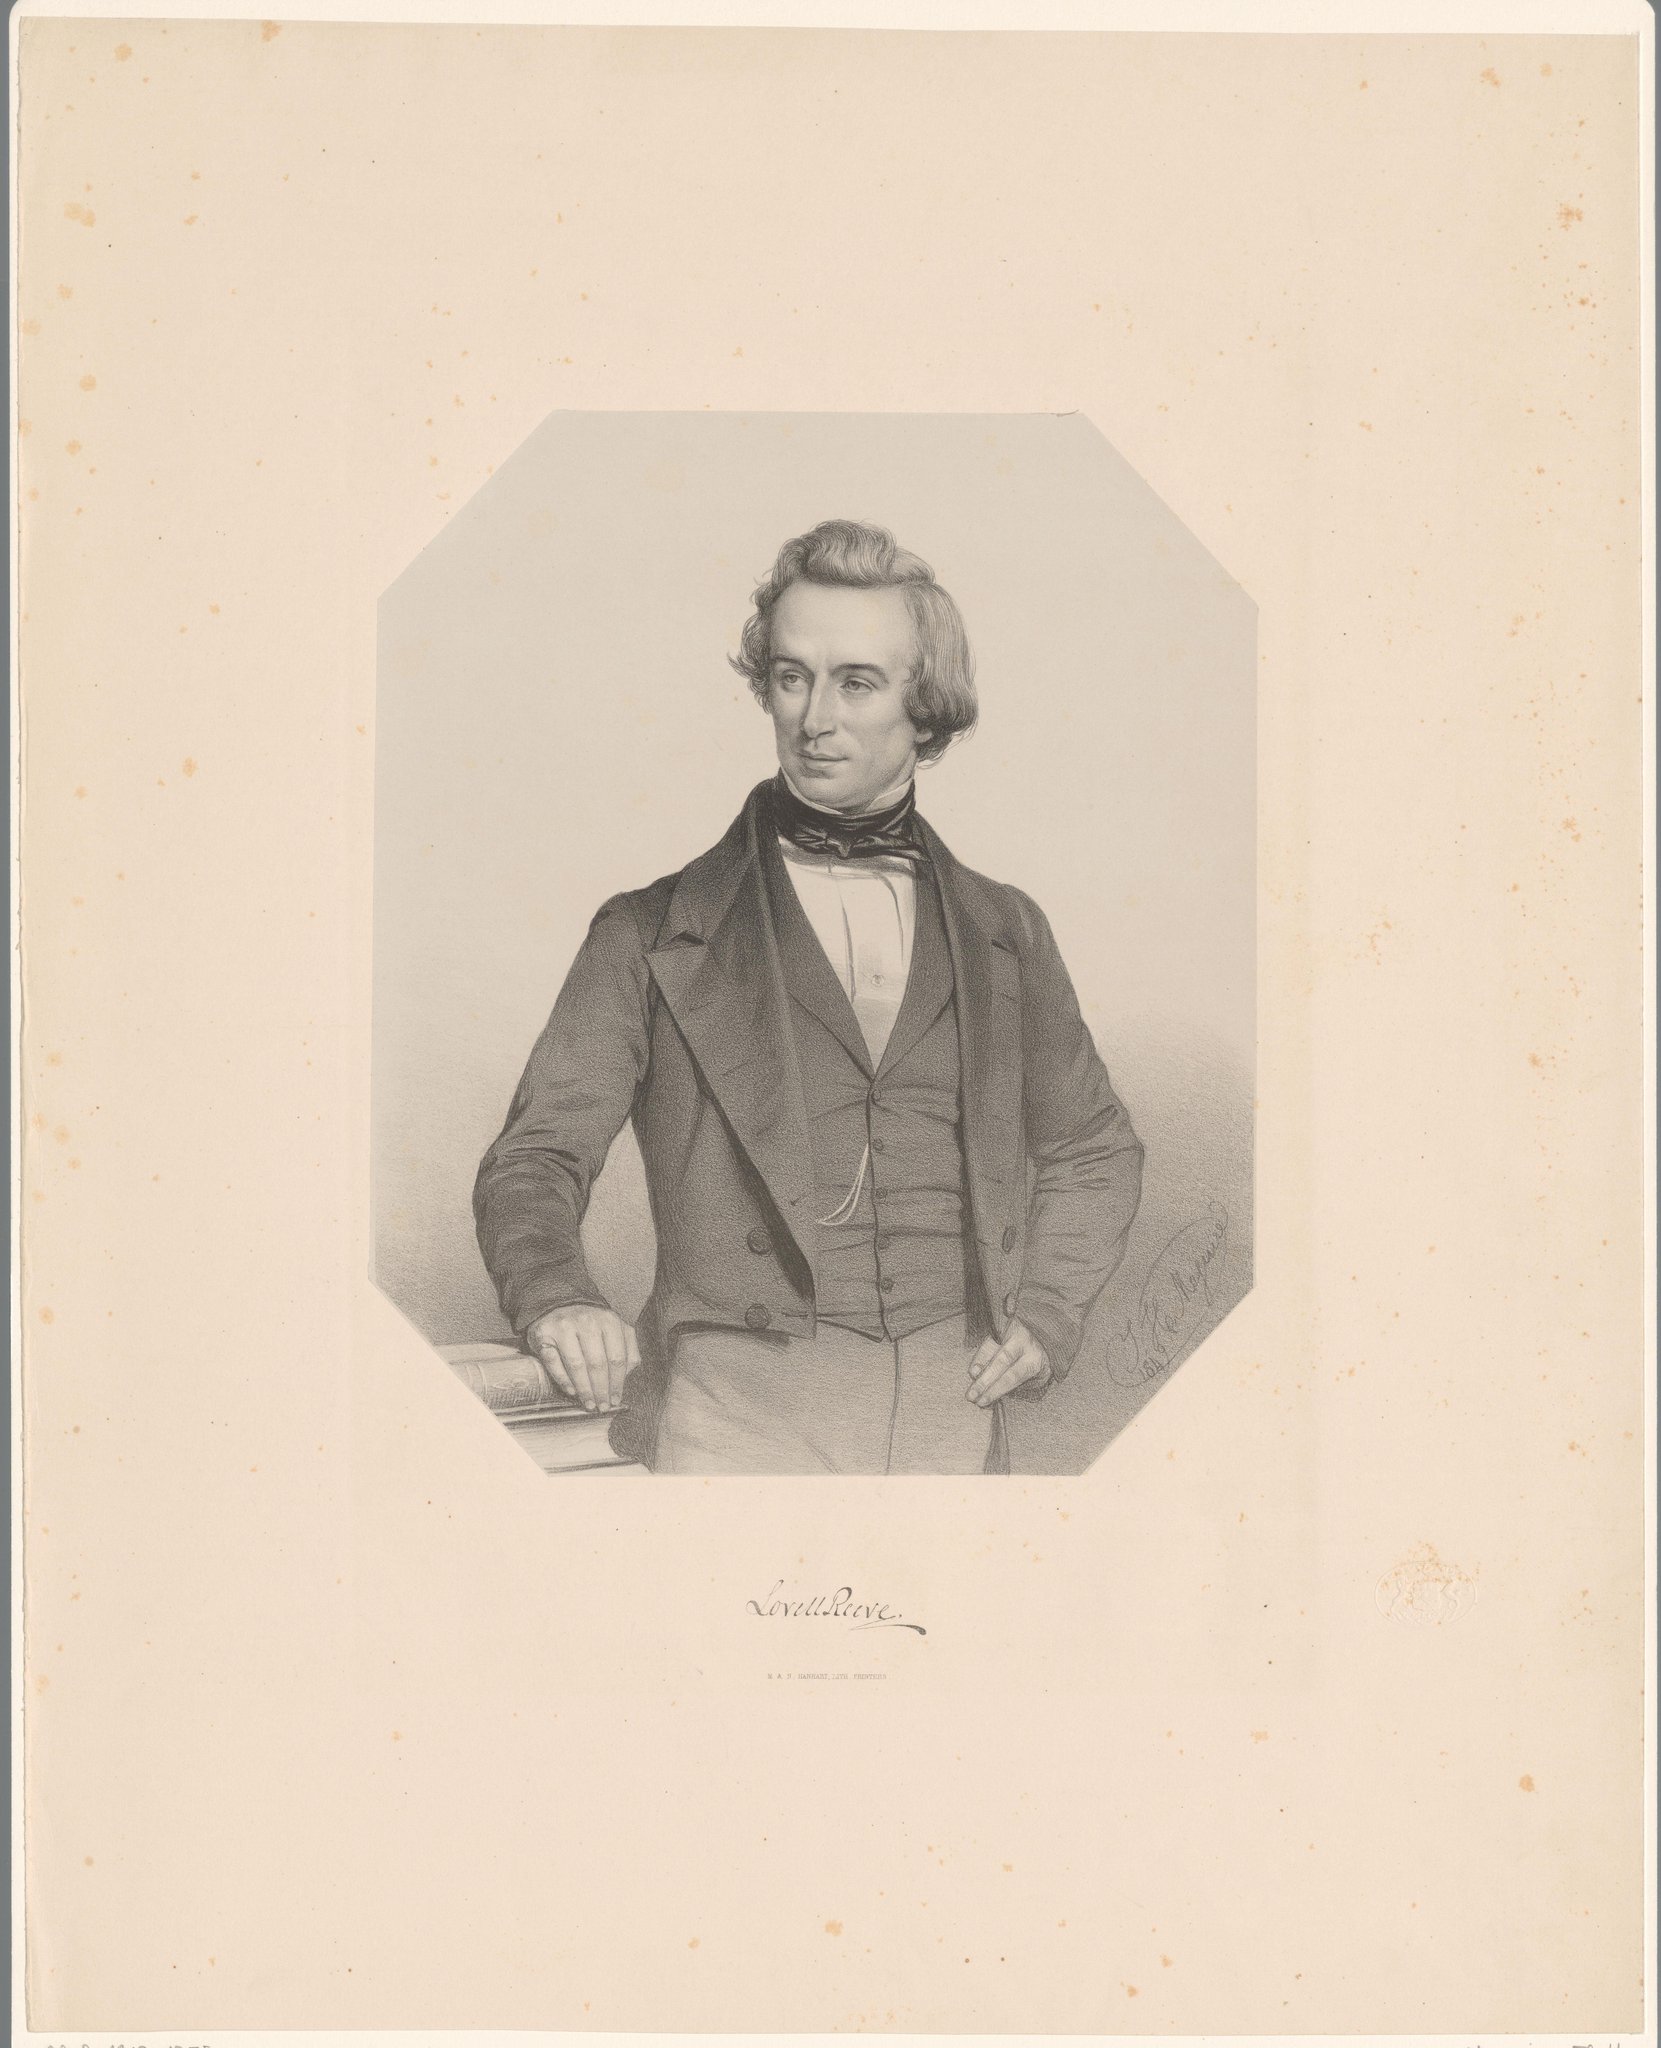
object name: print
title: Portretten uit het Ipswich Museum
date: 1852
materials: paper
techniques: lithograph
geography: london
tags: london, publisher, lovell augustus reeve, adult man, historical persons, book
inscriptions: collector's mark: Lugt 2228, check stamp: ‘Ipswich Museum’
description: Prent behoort tot de serie 'Ipswich Museum Portraits', ook bekend onder de titel 'Portraits of Honorary Members of the Ipswich Museum'. Deze serie is in 1852 door George Ransome uitgegeven en gedrukt door M&N Hanhart tussen 1848 en 1852. De serie bestaat uit ca. 60 portretten.